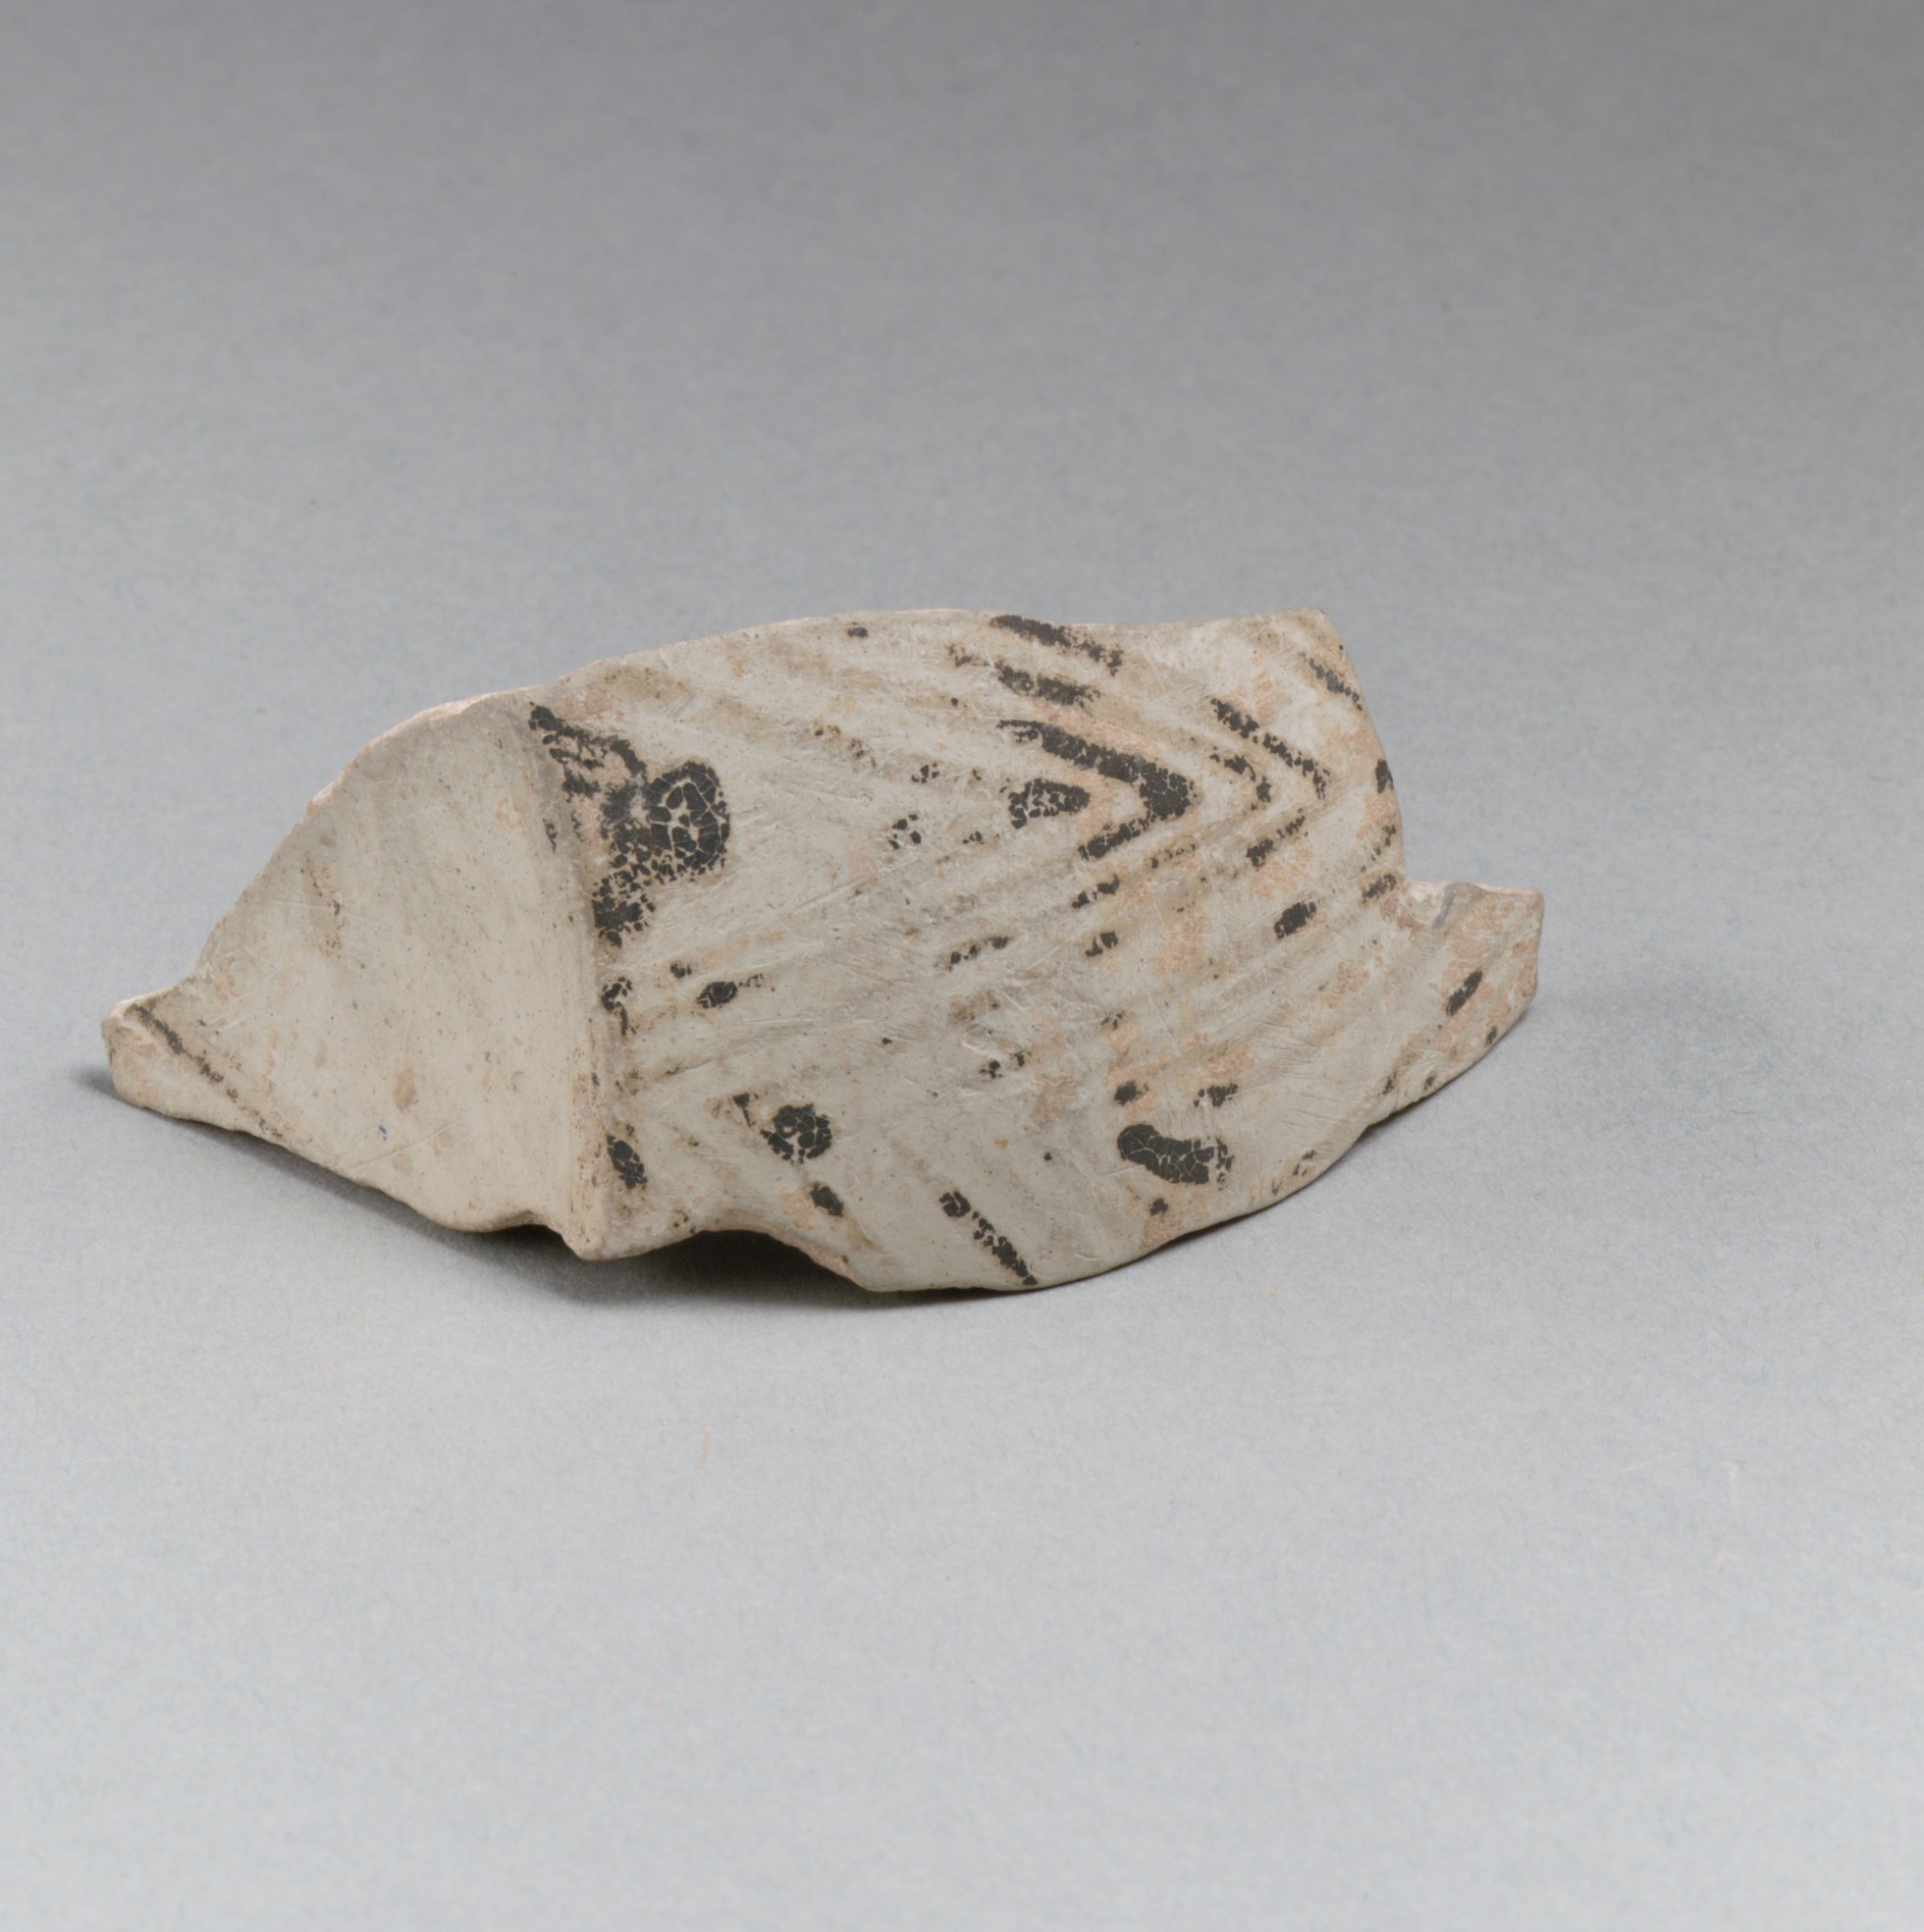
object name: vase fragment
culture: minoan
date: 1450-1400 BCE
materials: terracotta